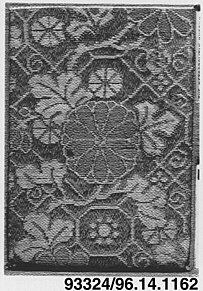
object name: piece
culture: japanese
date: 1701-1900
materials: silk